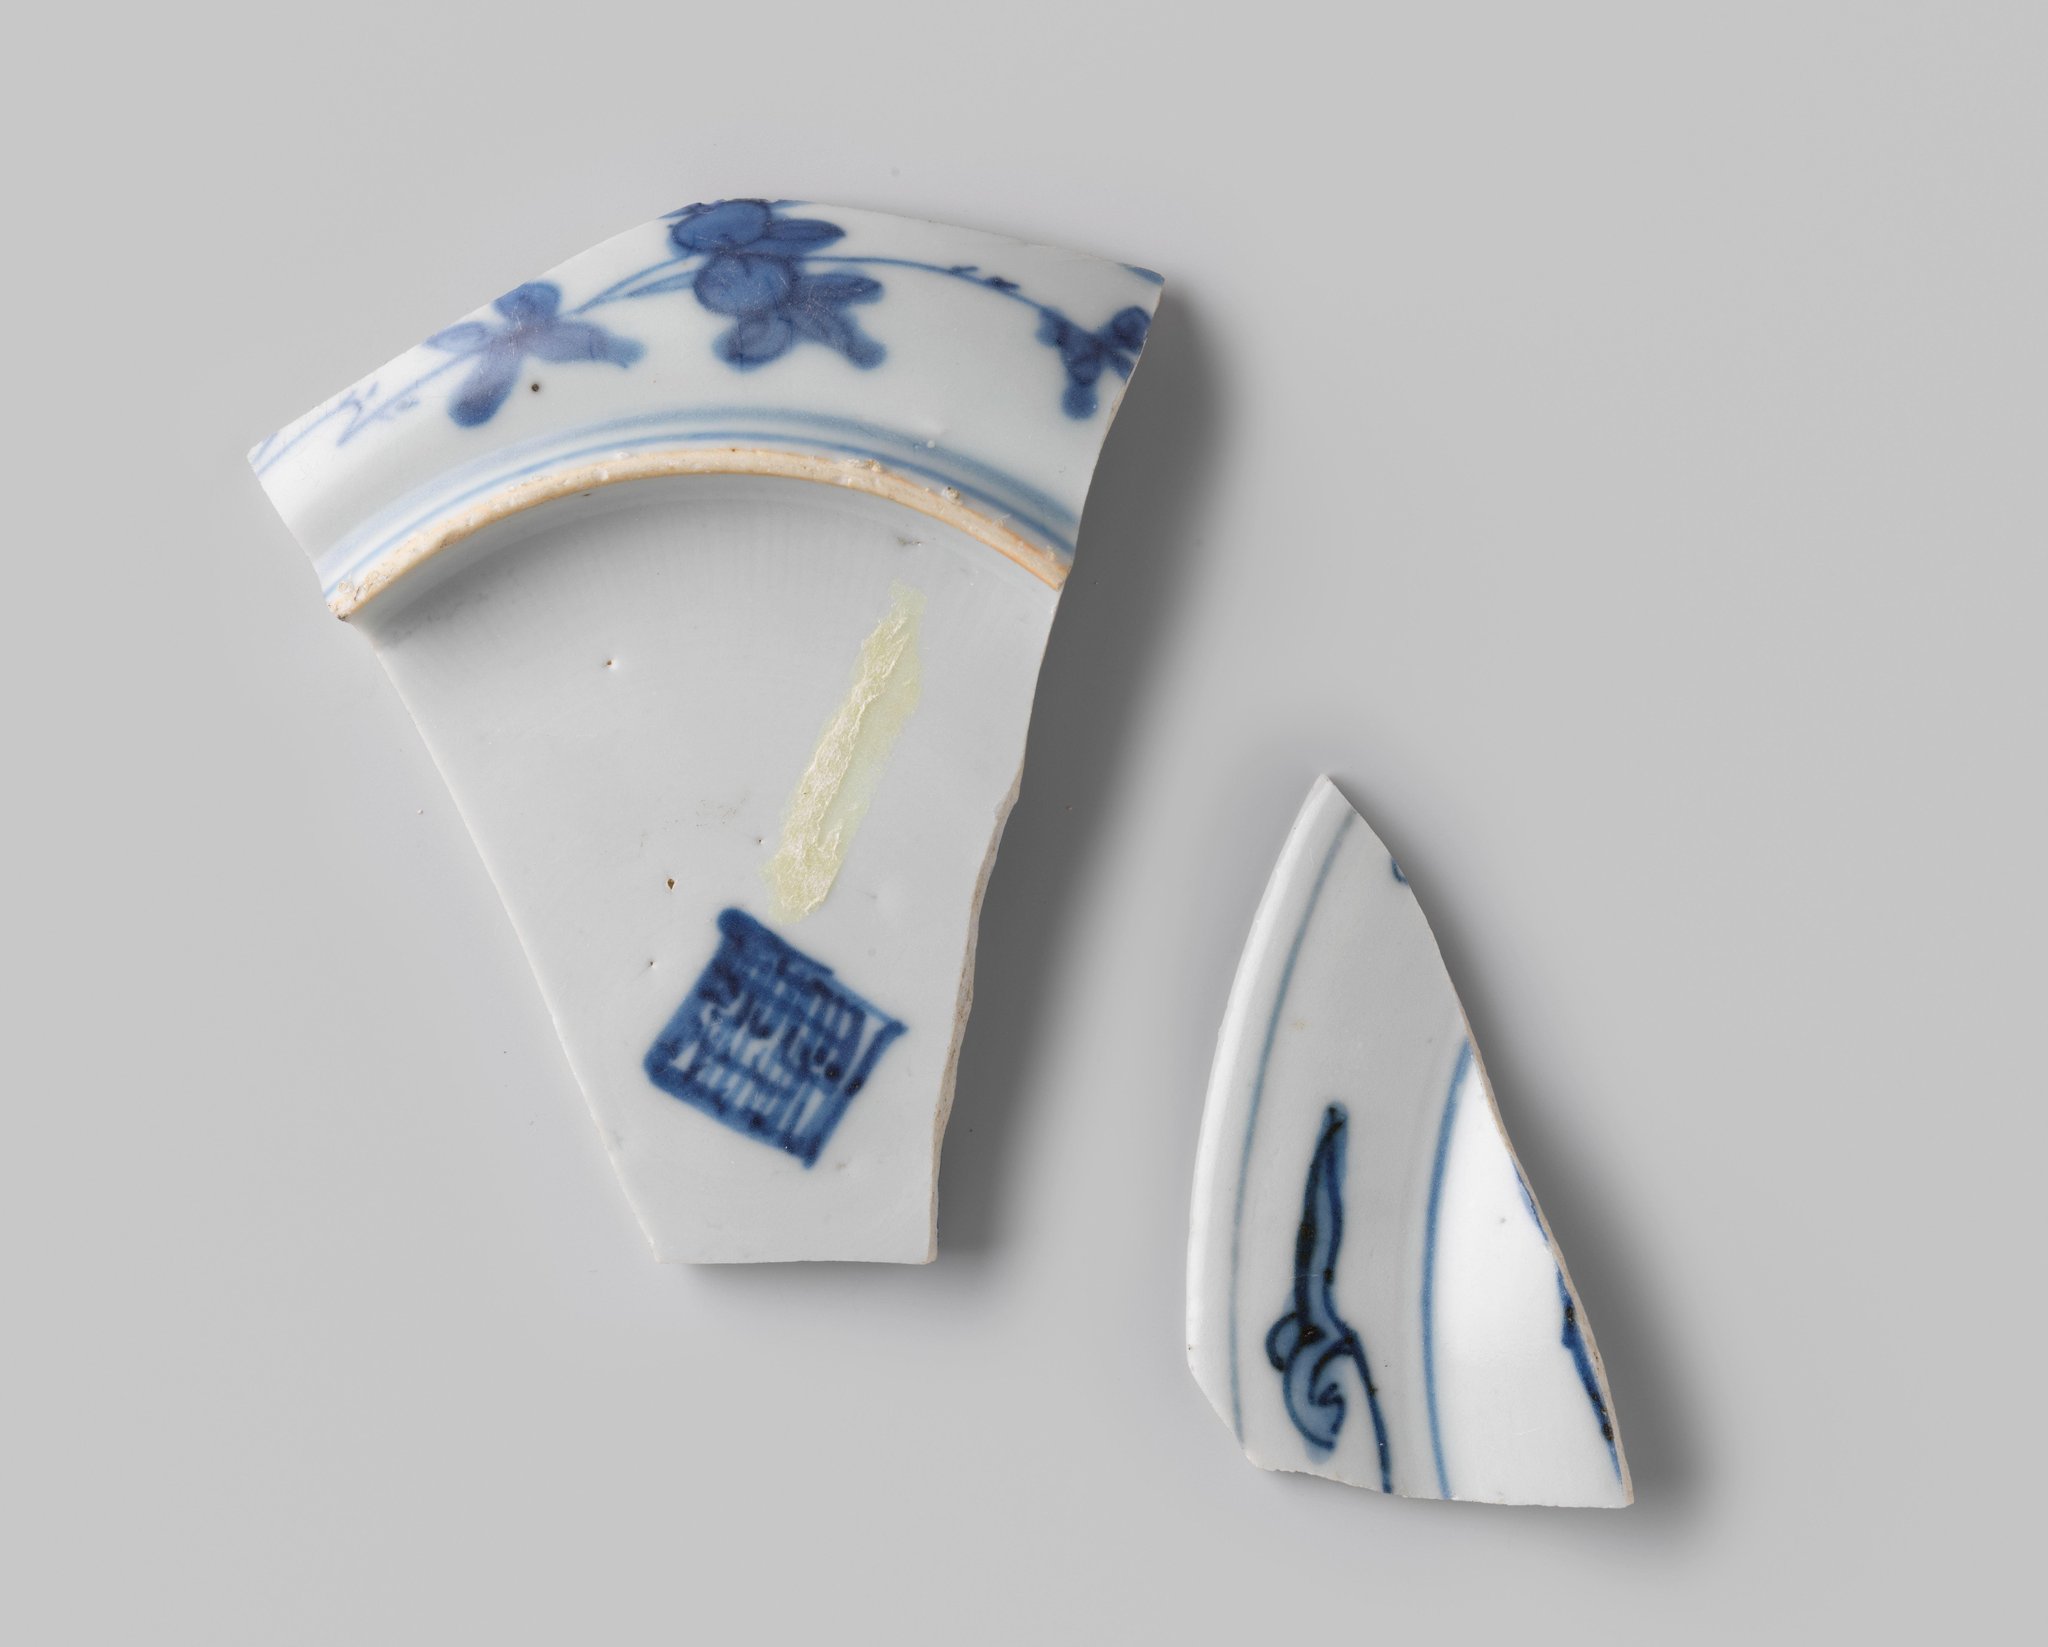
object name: sherd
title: Scherven van borden uit V.O.C.-schip de 'Witte Leeuw'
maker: Anonymous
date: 1613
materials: porcelain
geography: jingdezhen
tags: verenigde oostindische compagnie, sint-helena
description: A plate with a flattened rim. In the centre a phoenix standing on a rock with at its side a small bird, a flower and above some clouds. Around this design is a thin band of scrolls. The cavetto is blank. On the lip-rim a band which is drawn alternatingly a flower, castanets lozenge and a scroll, also there are four stems with a small flower with a group of dots in between. On the outside twice a long stem with three tiny peaches with in between a small circle.